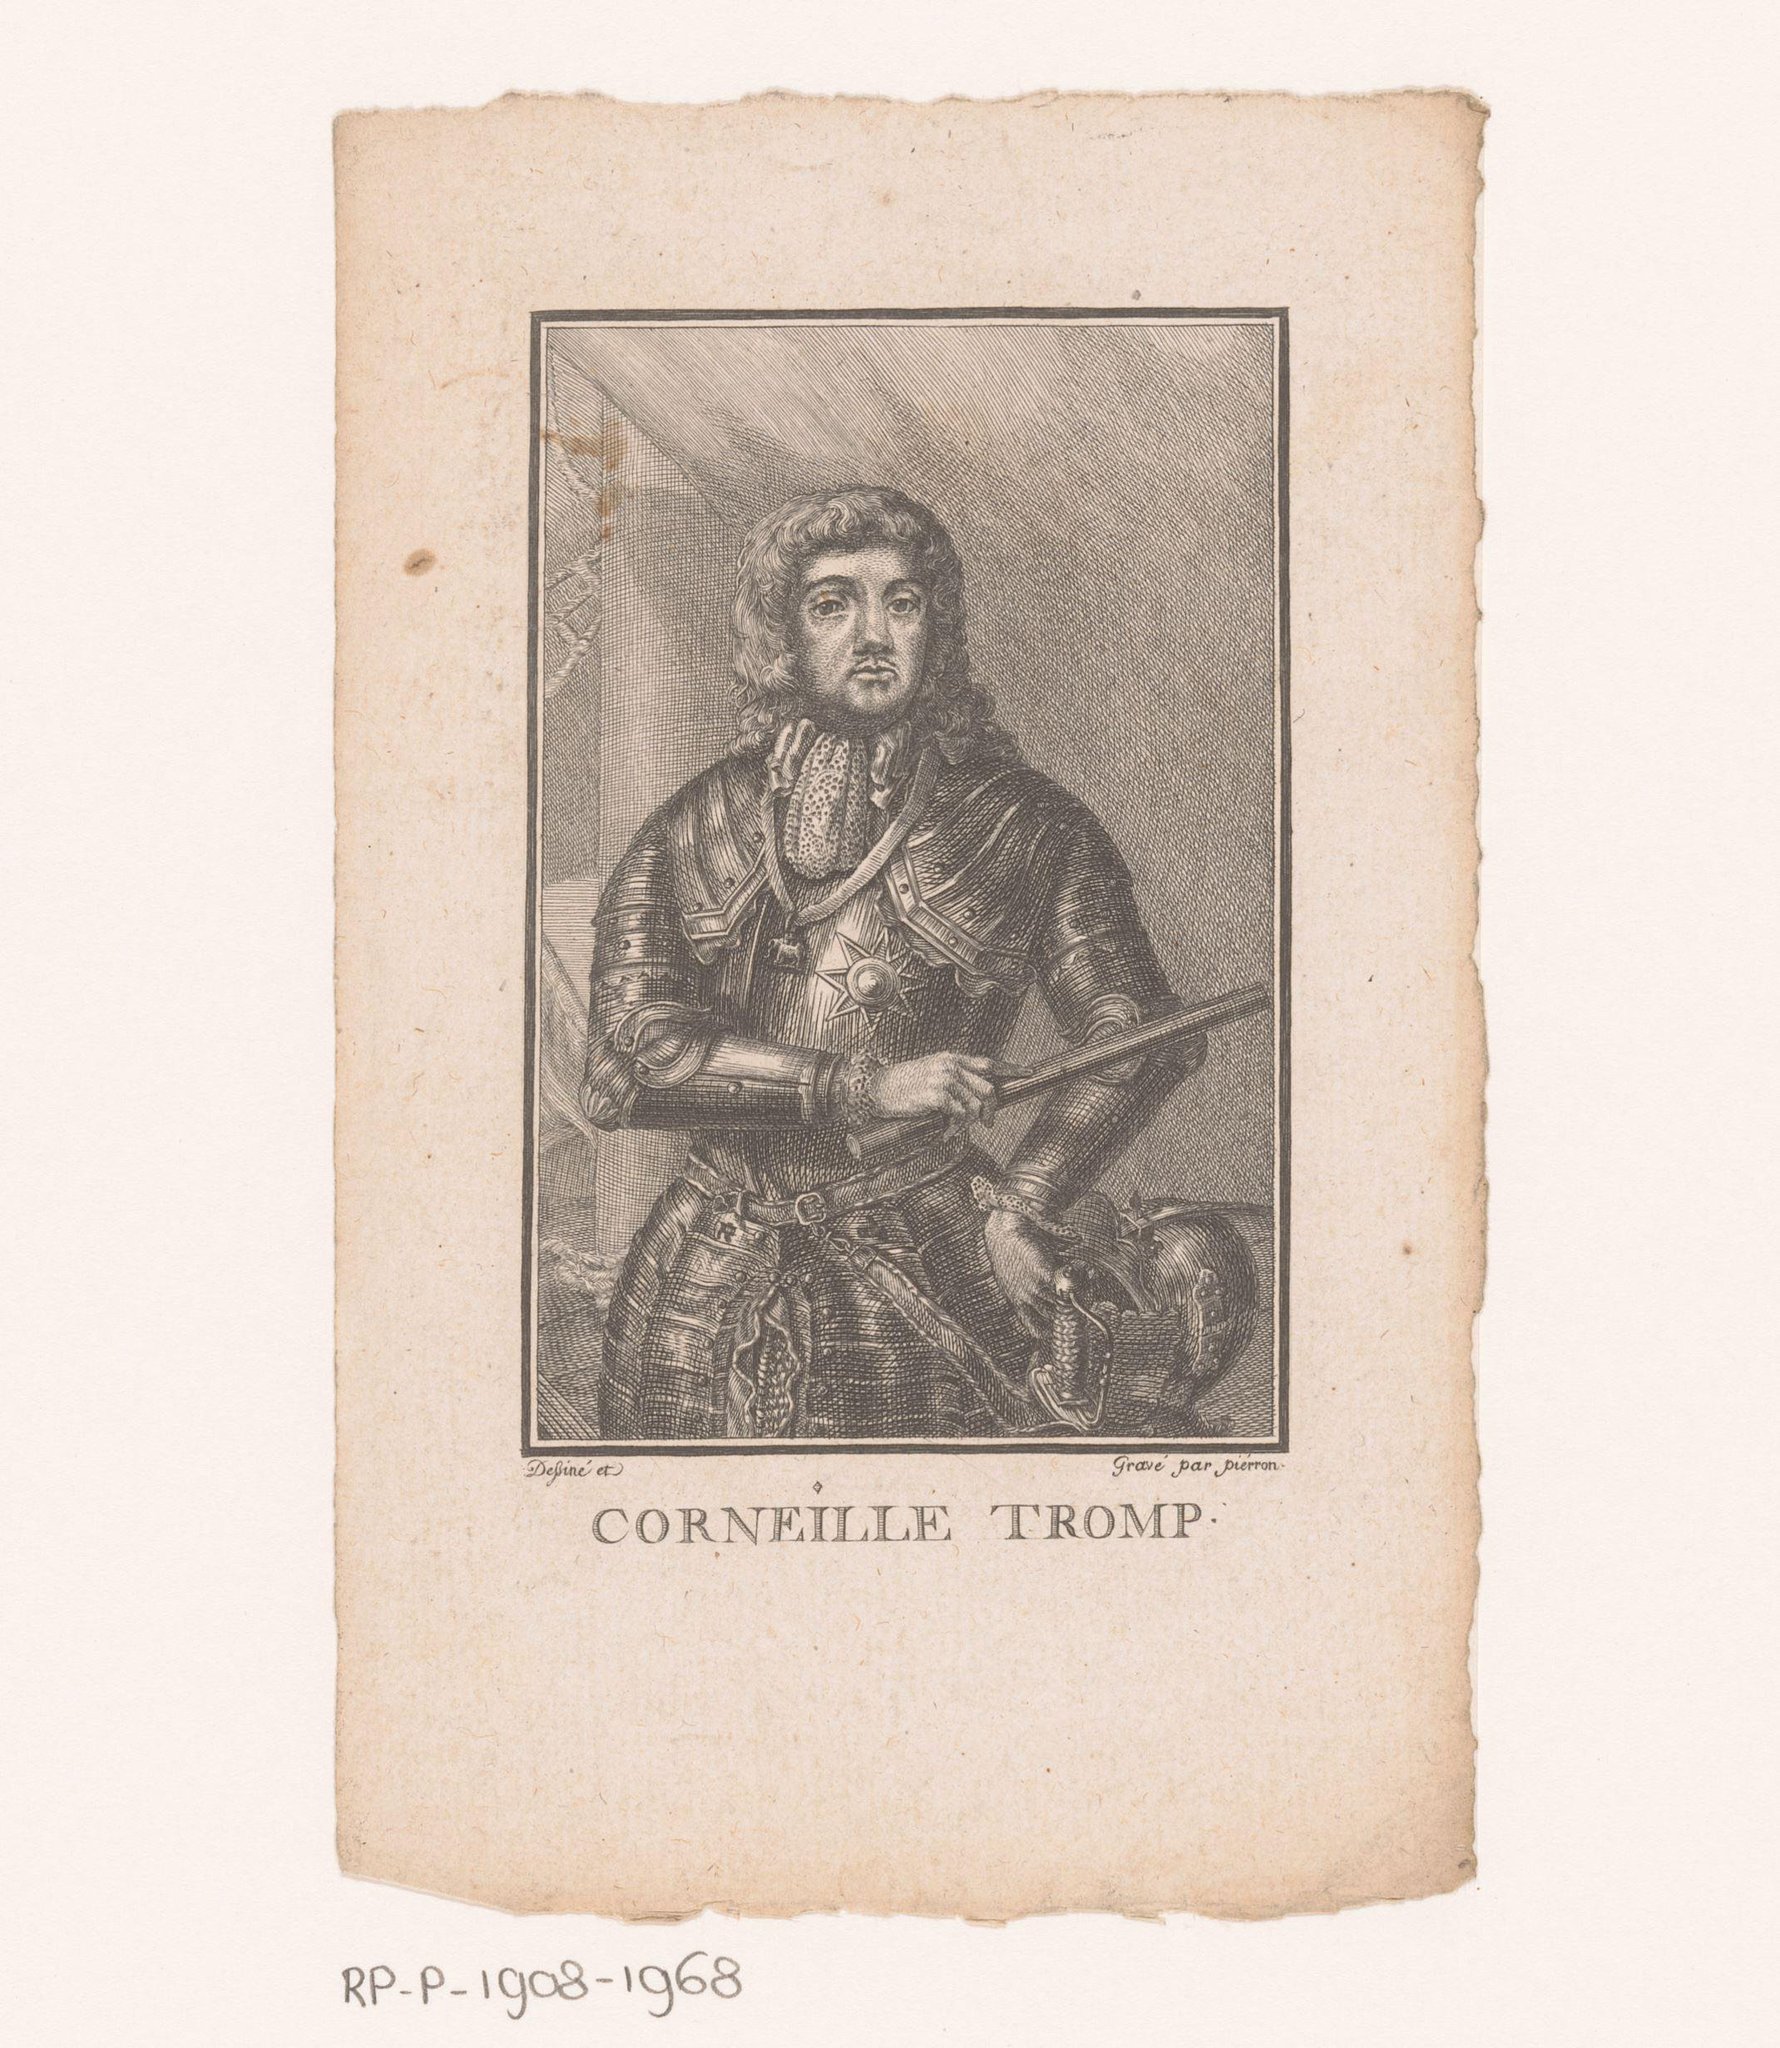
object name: print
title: Portret van Cornelis Tromp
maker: jean antoine pierron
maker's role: print maker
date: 1780-1812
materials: paper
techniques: etching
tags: rotterdam, amsterdam, cornelis tromp, historical persons, seaman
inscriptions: collector's mark: Lugt 2228